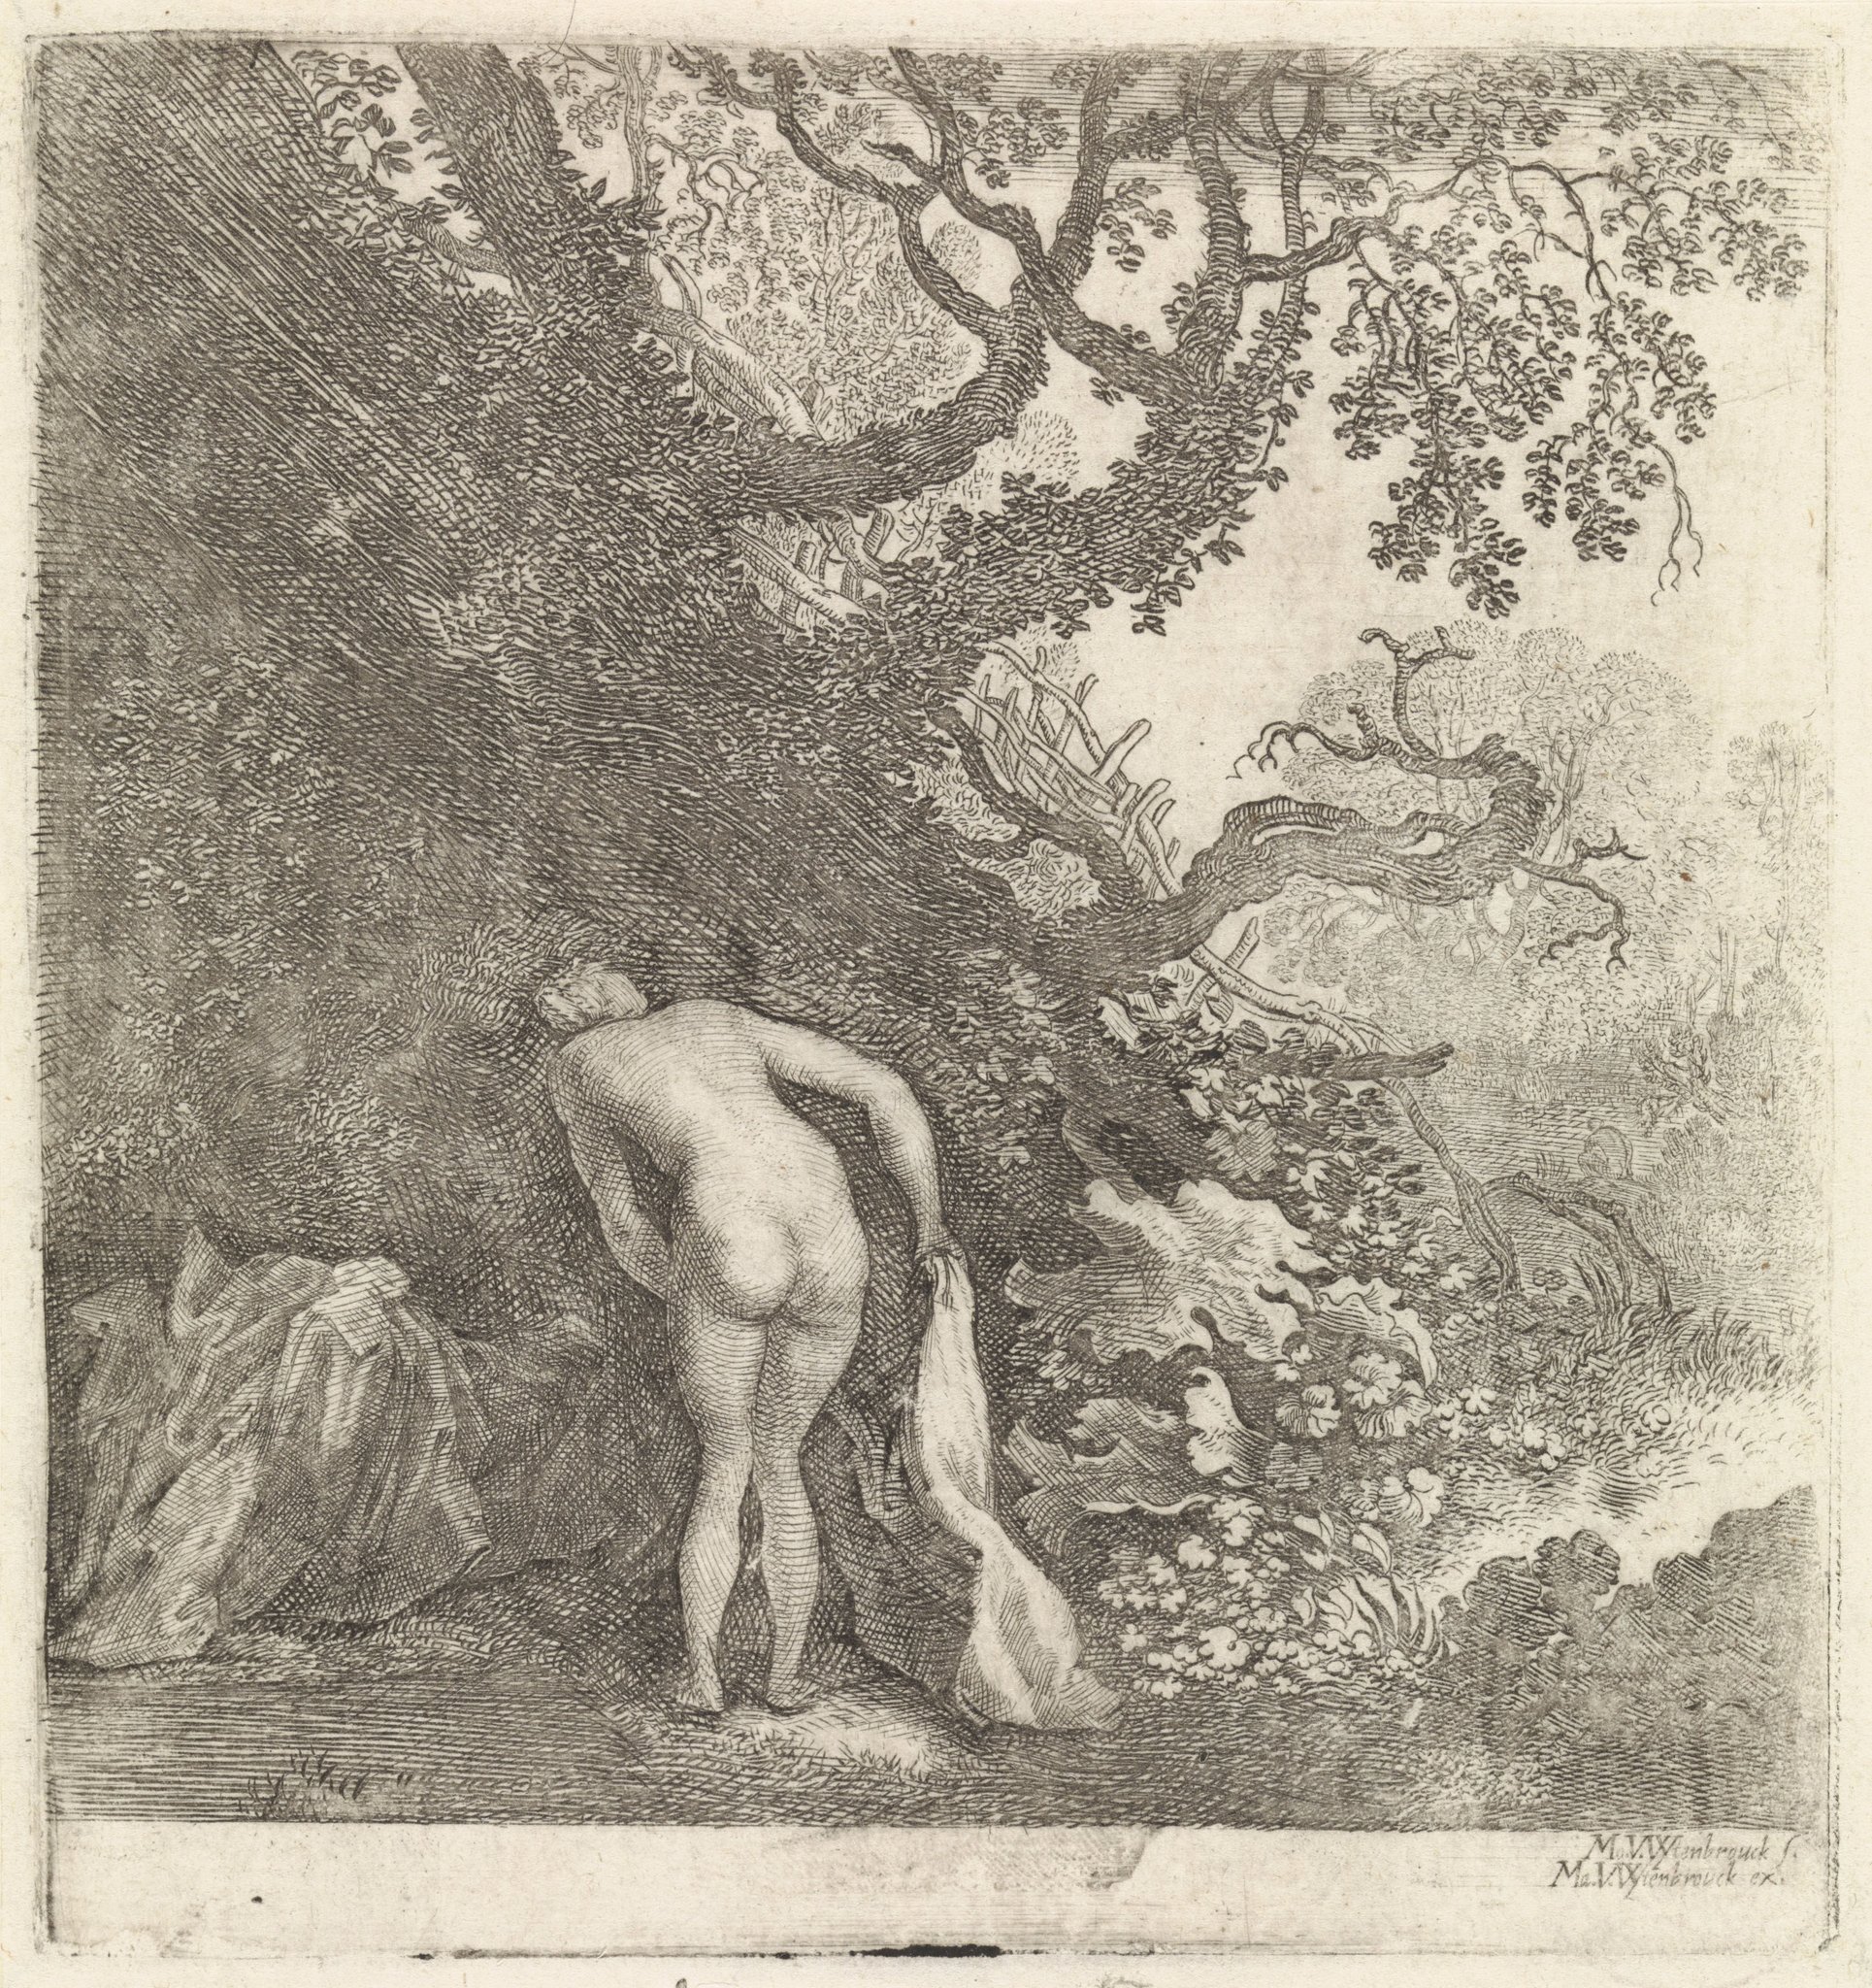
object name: print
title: Badende vrouw, van achteren gezien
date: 1600-1647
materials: paper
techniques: engraving, etching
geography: antwerp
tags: 'après le bain' - aa - in the open air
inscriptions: collector's mark: Lugt 240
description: Een naakte vrouw, aan de rand van een bosmeertje, buigt zich over haar op de grond liggende kleding.